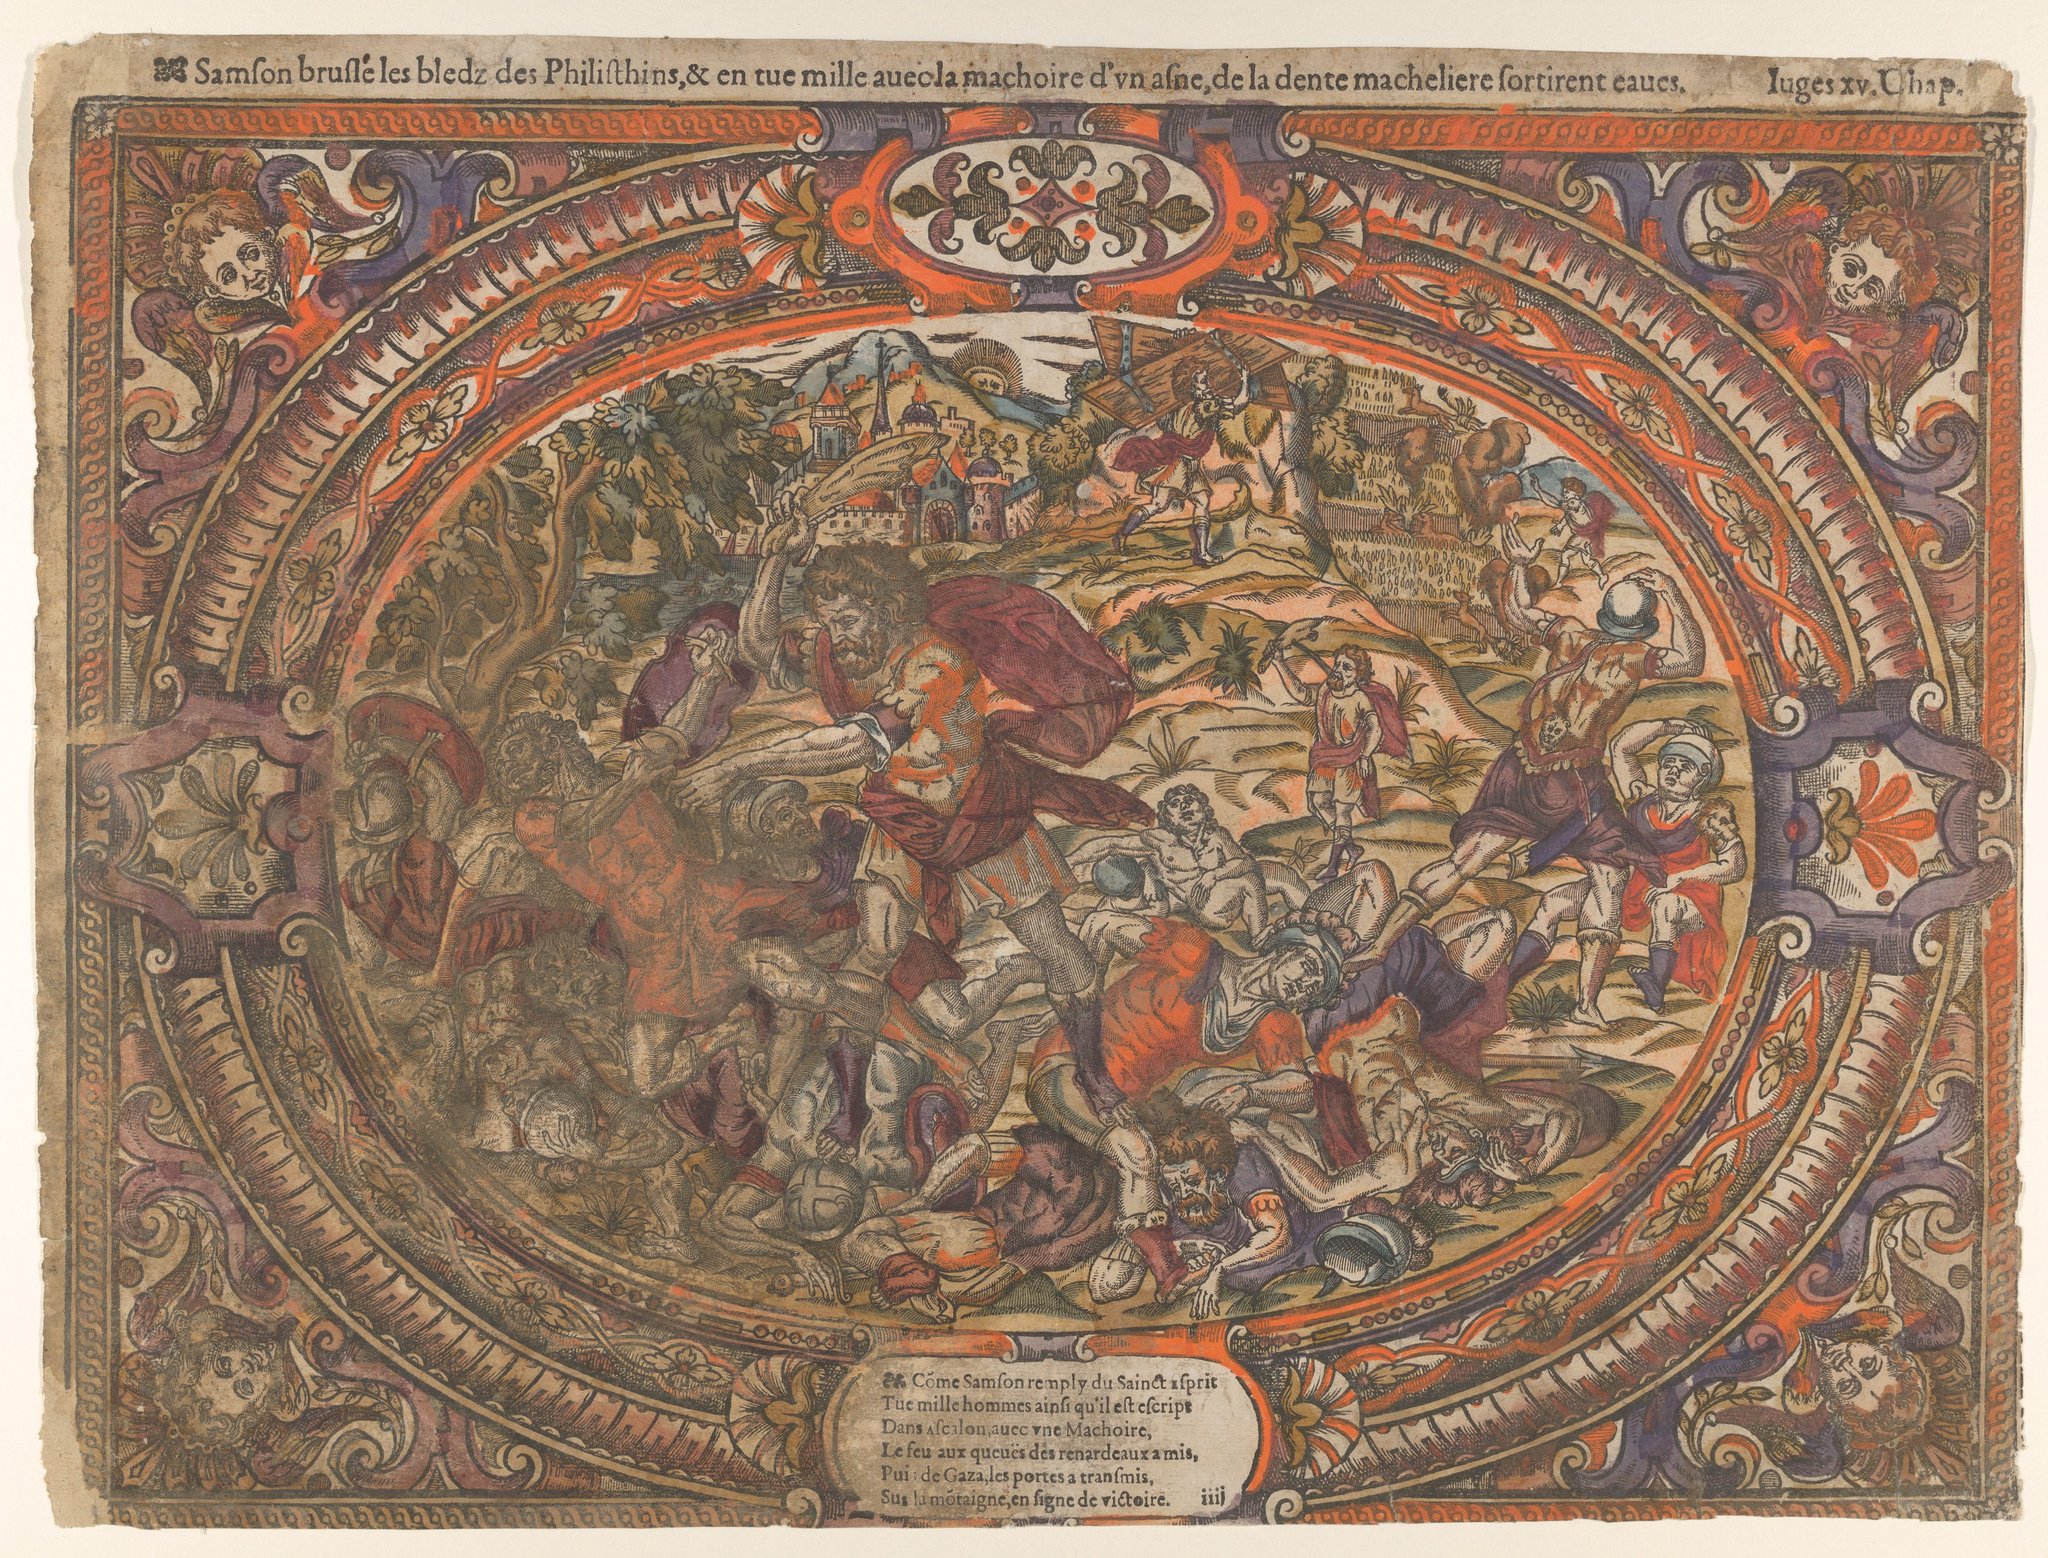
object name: print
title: Battle against the Philistines, from "The Story of Samson"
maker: anonymous, french, 16th century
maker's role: artist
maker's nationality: french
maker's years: 1500-1600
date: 1560-1580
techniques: hand coloring, pochoir, woodcut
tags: battles,faces,men,samson